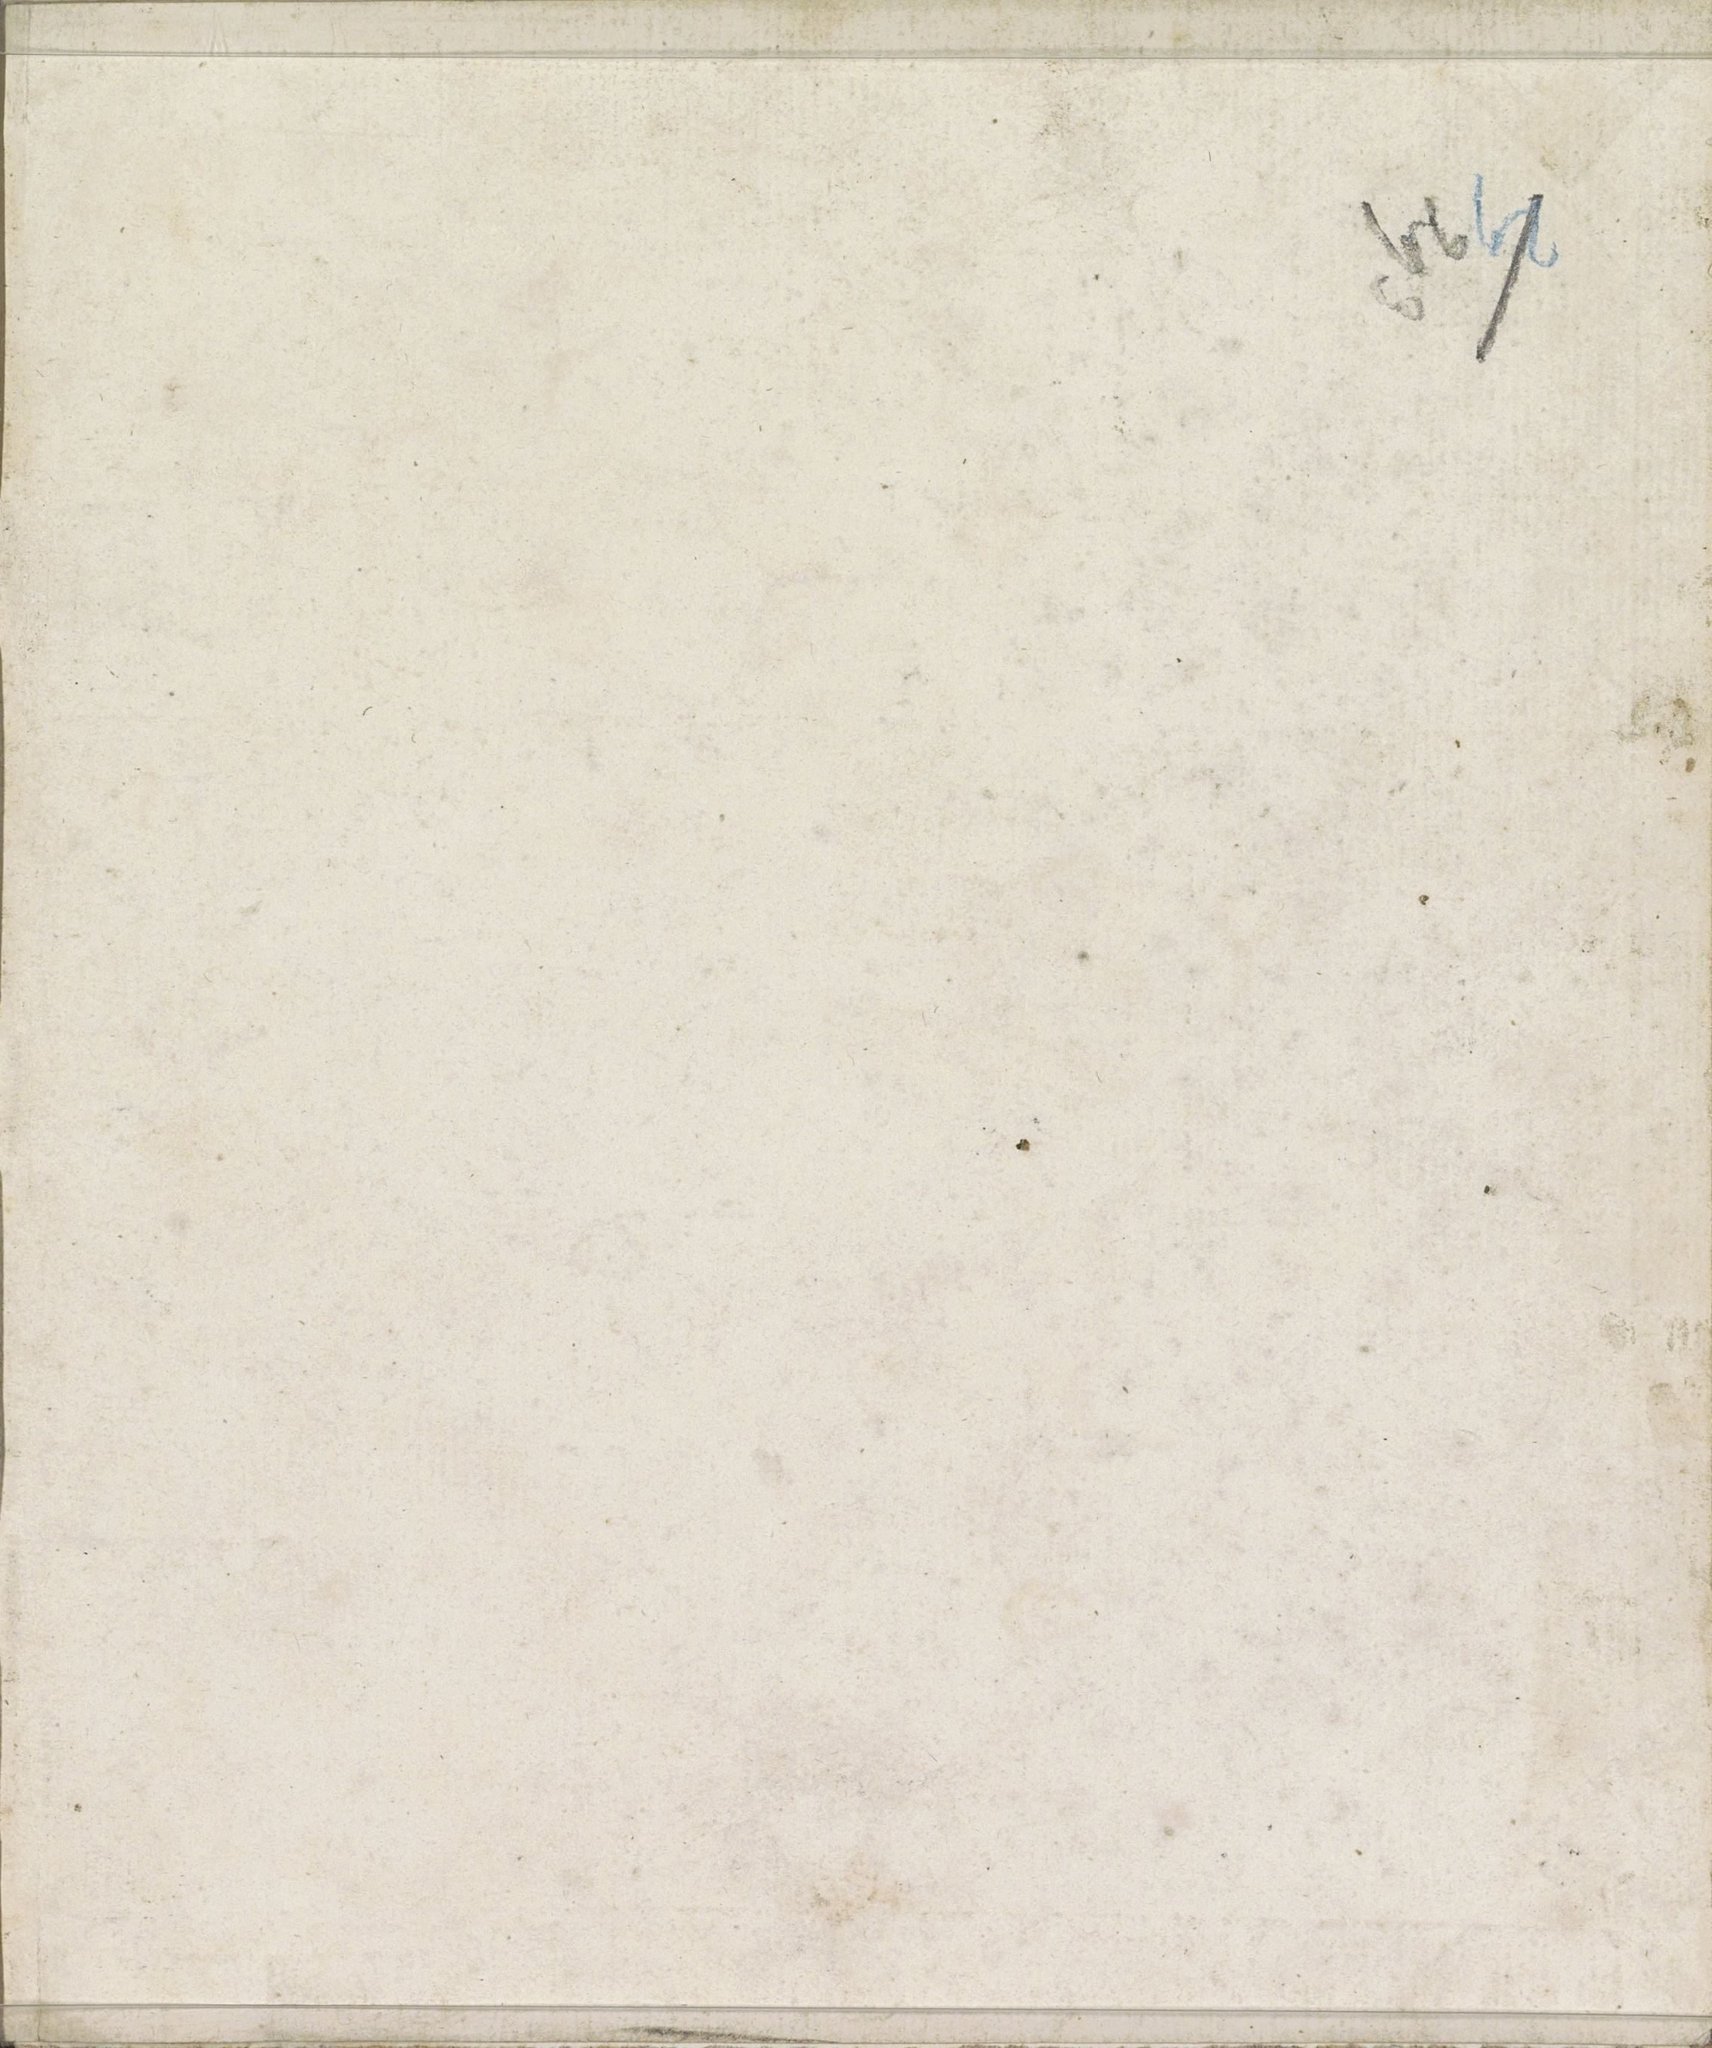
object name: sketchbook leaf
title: Nummer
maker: andreas schelfhout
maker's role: draughtsman, painter, print maker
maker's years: 1787-1870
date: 1828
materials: chalk, paper, pencil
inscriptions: annotation: ‘566[...]’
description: Blad 95 recto uit een schetsboek met 95 bladen.